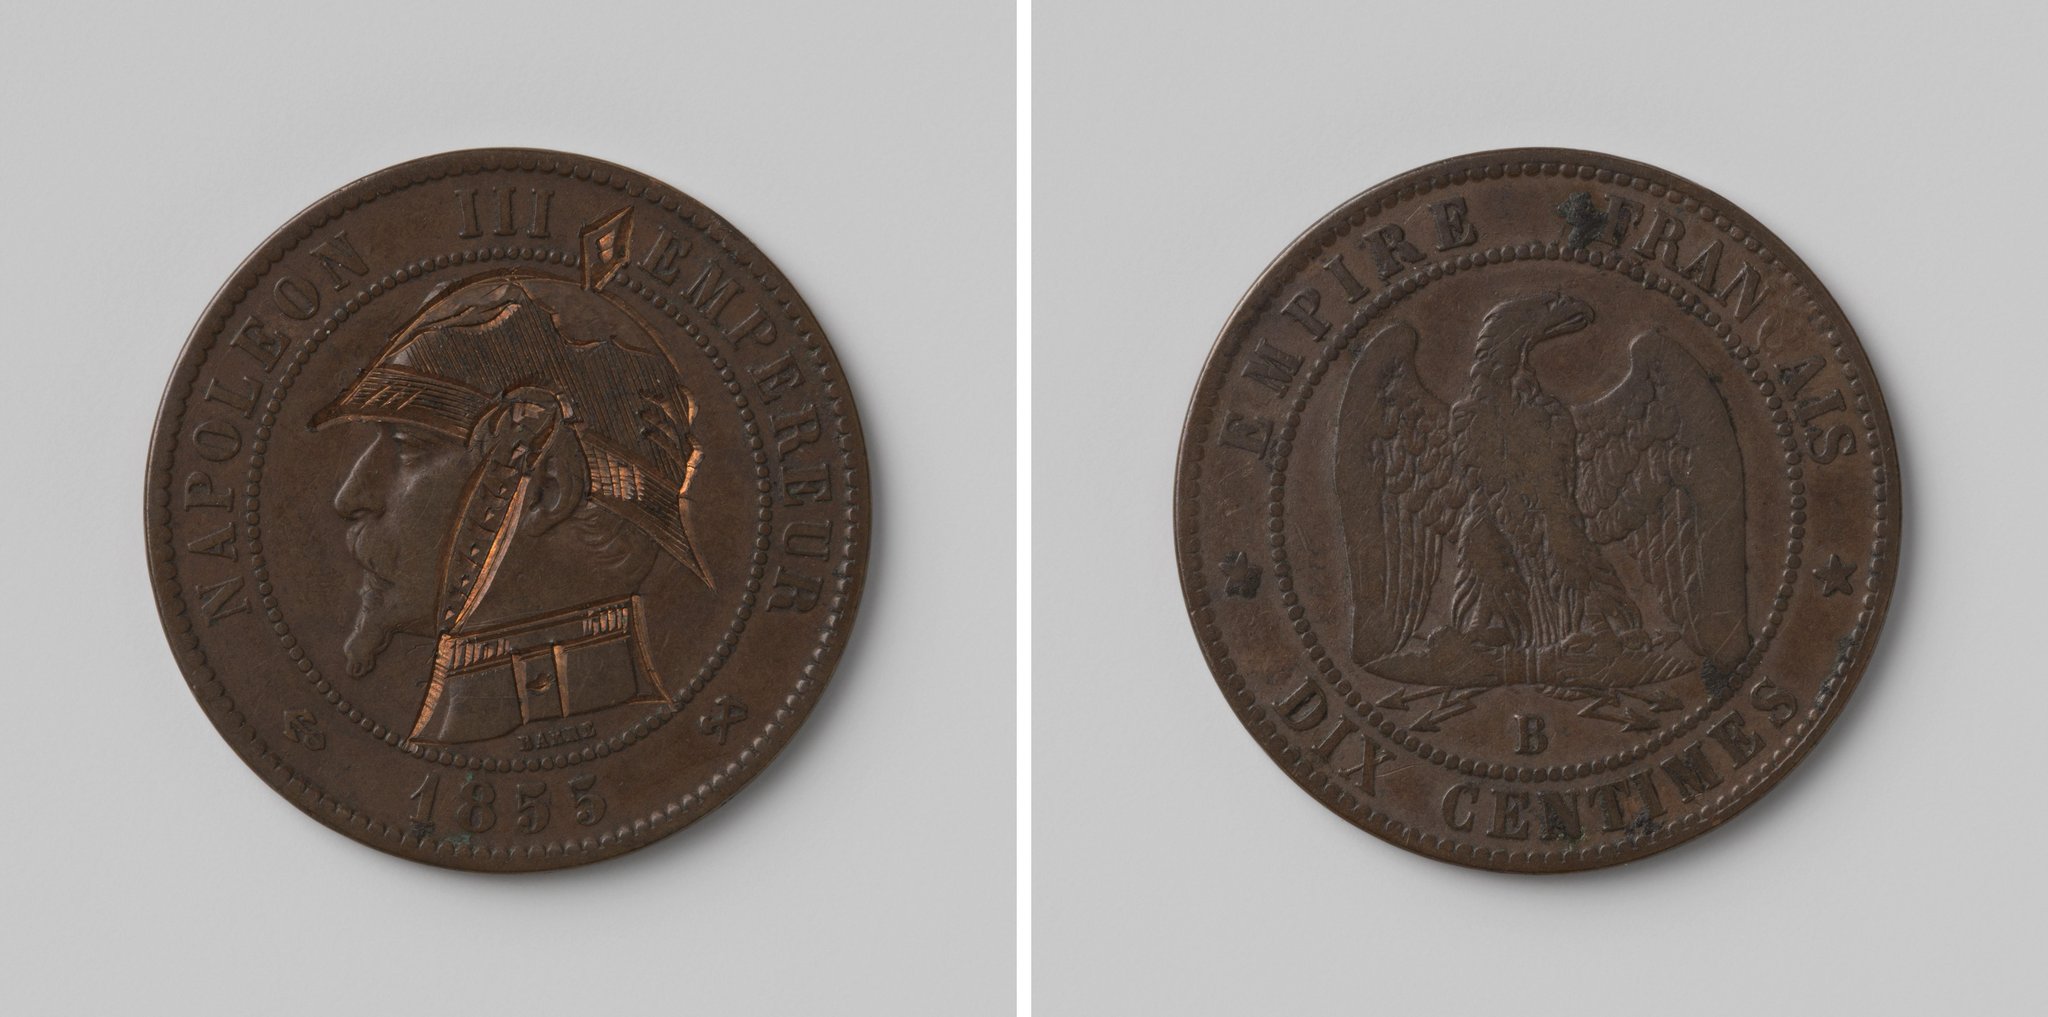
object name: coin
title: Napoleon III Bonaparte, keizer der Fransen, spotpenning vervaardigd uit munt van tien centimes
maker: jean jacques barre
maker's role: print maker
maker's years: 1793-1855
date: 1855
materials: copper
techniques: engraving, striking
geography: paris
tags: paris, london, napoleon iii (keizer der fransen)